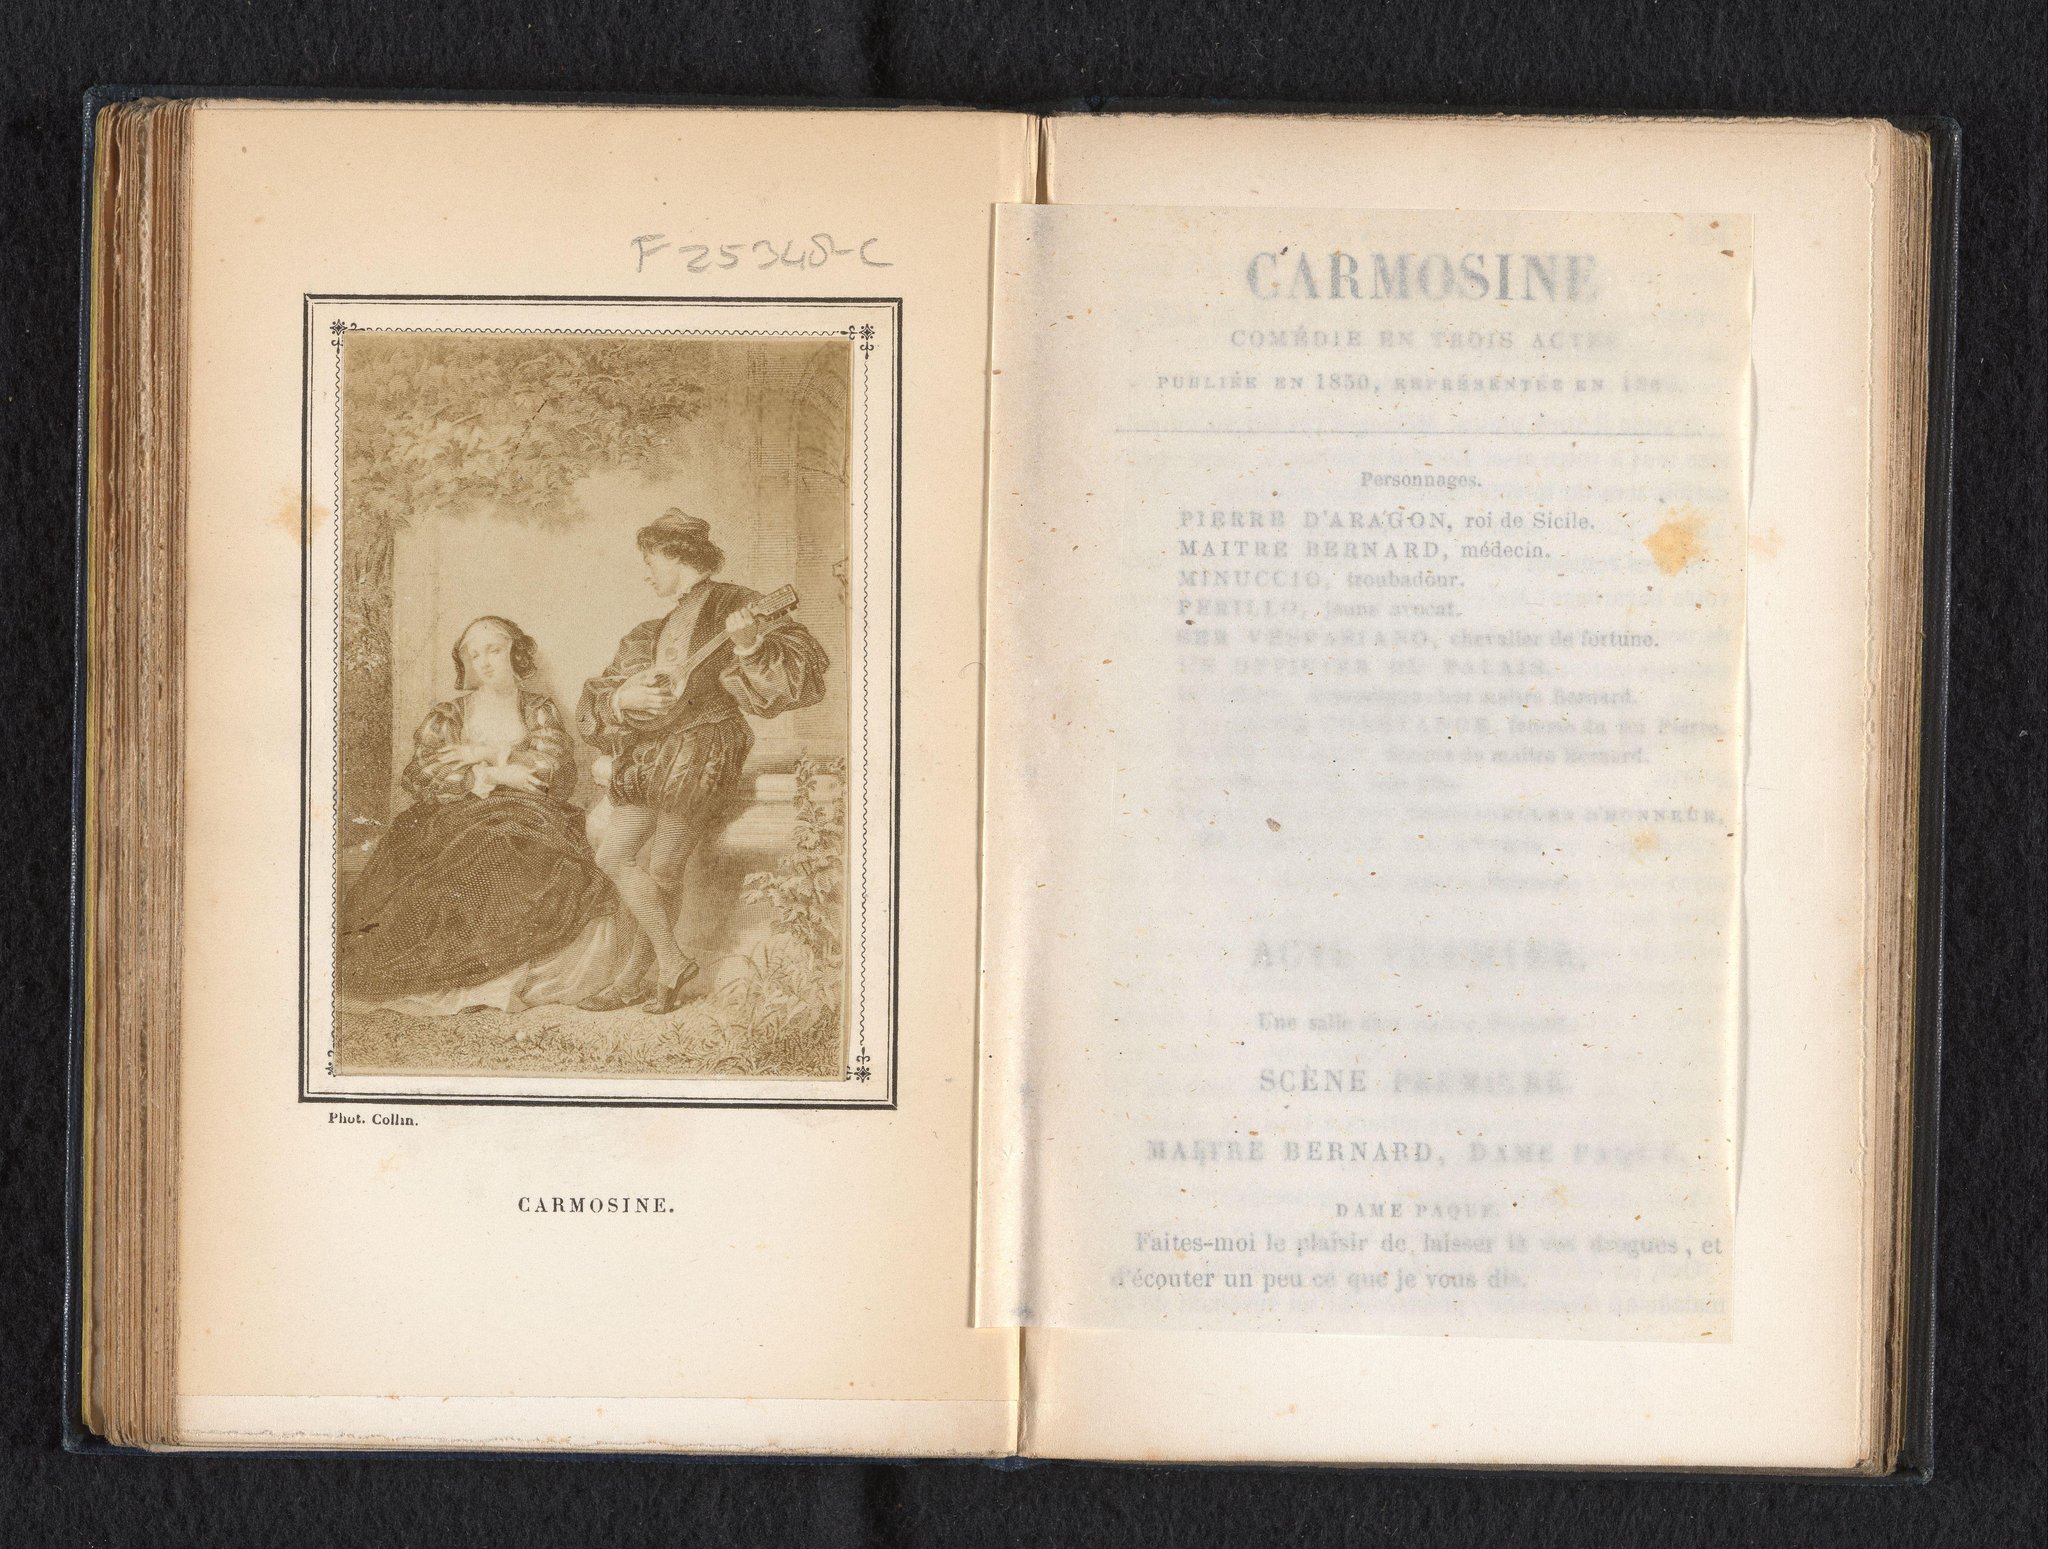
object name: photograph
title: Carmosine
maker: collin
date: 1852-1867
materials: paper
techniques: albumen print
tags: print, e.g.: engraving, etching, lithograph